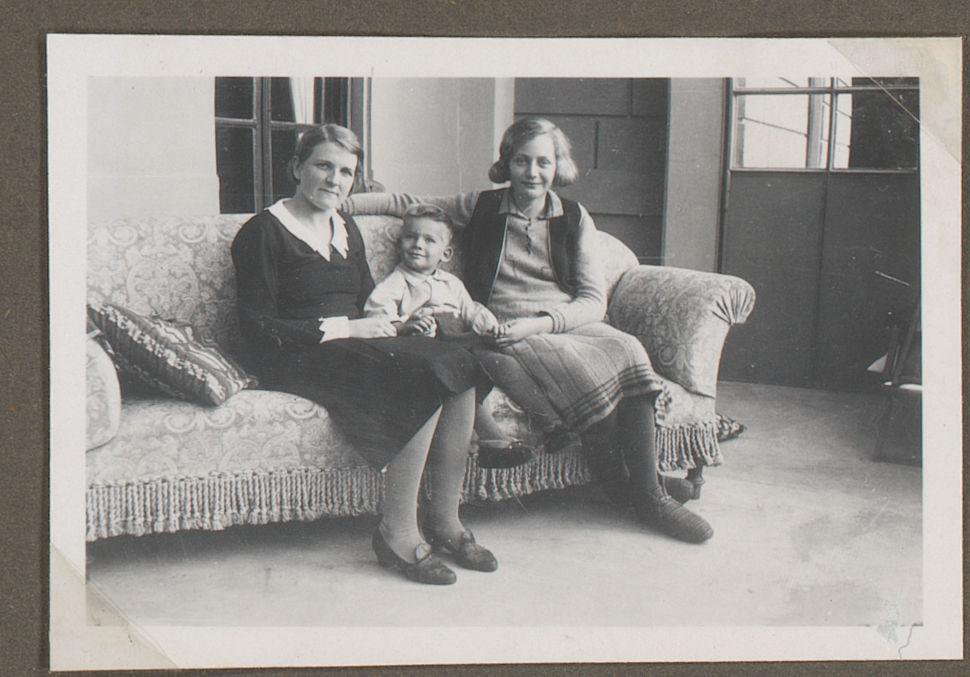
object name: album leaf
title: Portret van Sietske Streekstra, Martha en Hein van Steenis op een sofa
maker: Anonymous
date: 1934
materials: photographic support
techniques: gelatin silver print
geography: switzerland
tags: family group, especially parents with their child(ren), historical persons, couch, sofa, settee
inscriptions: number: ‘67’